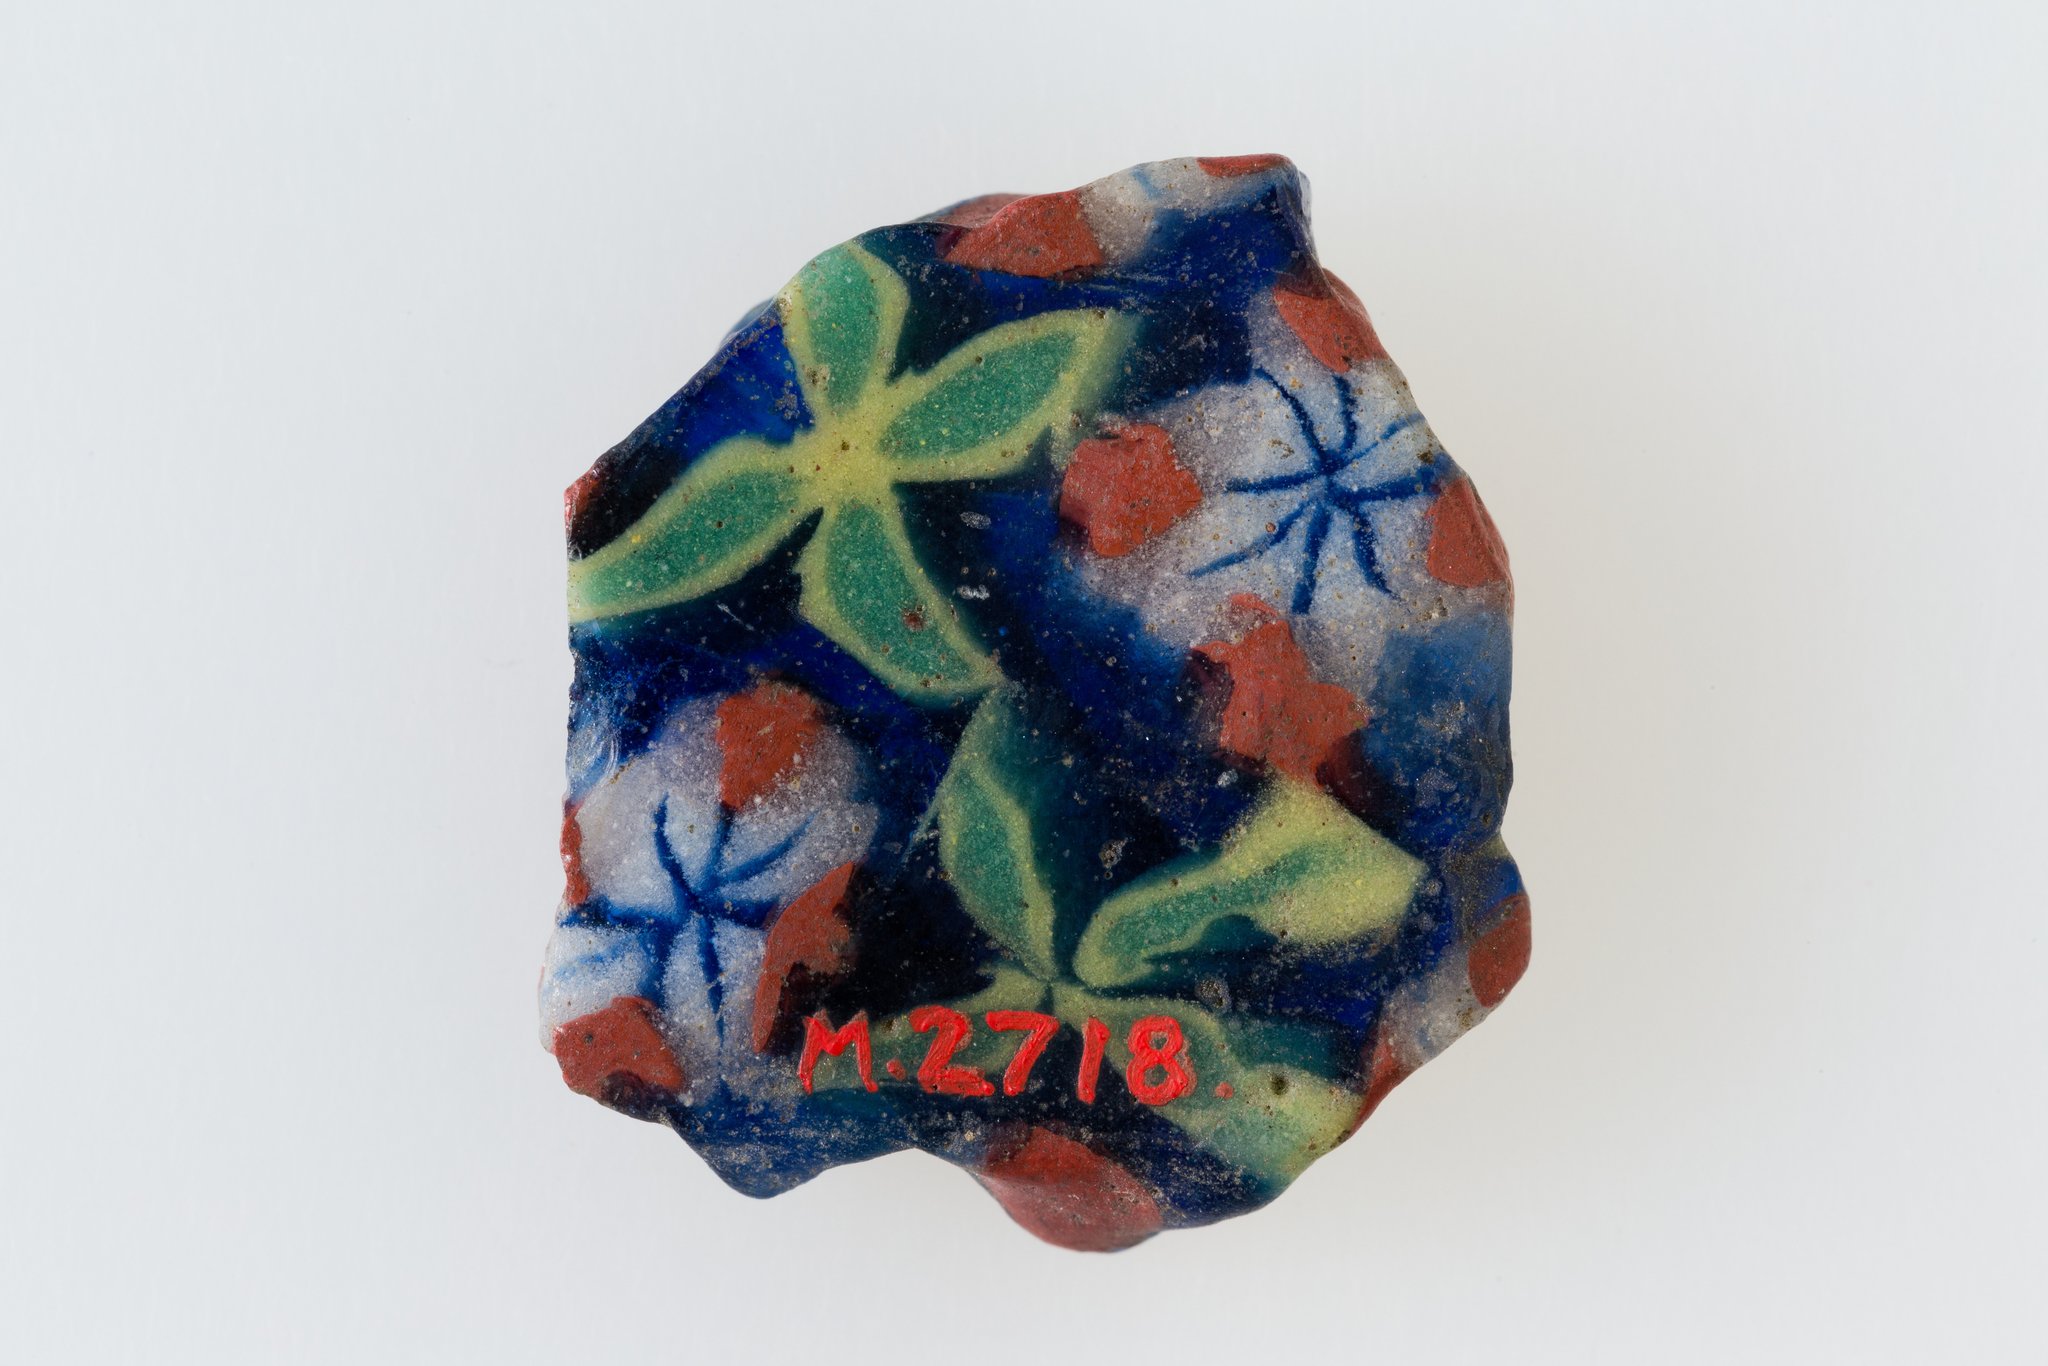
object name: inlay fragment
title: Vase fragment, conventional floral design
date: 1-300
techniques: mosaic glass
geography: egypt